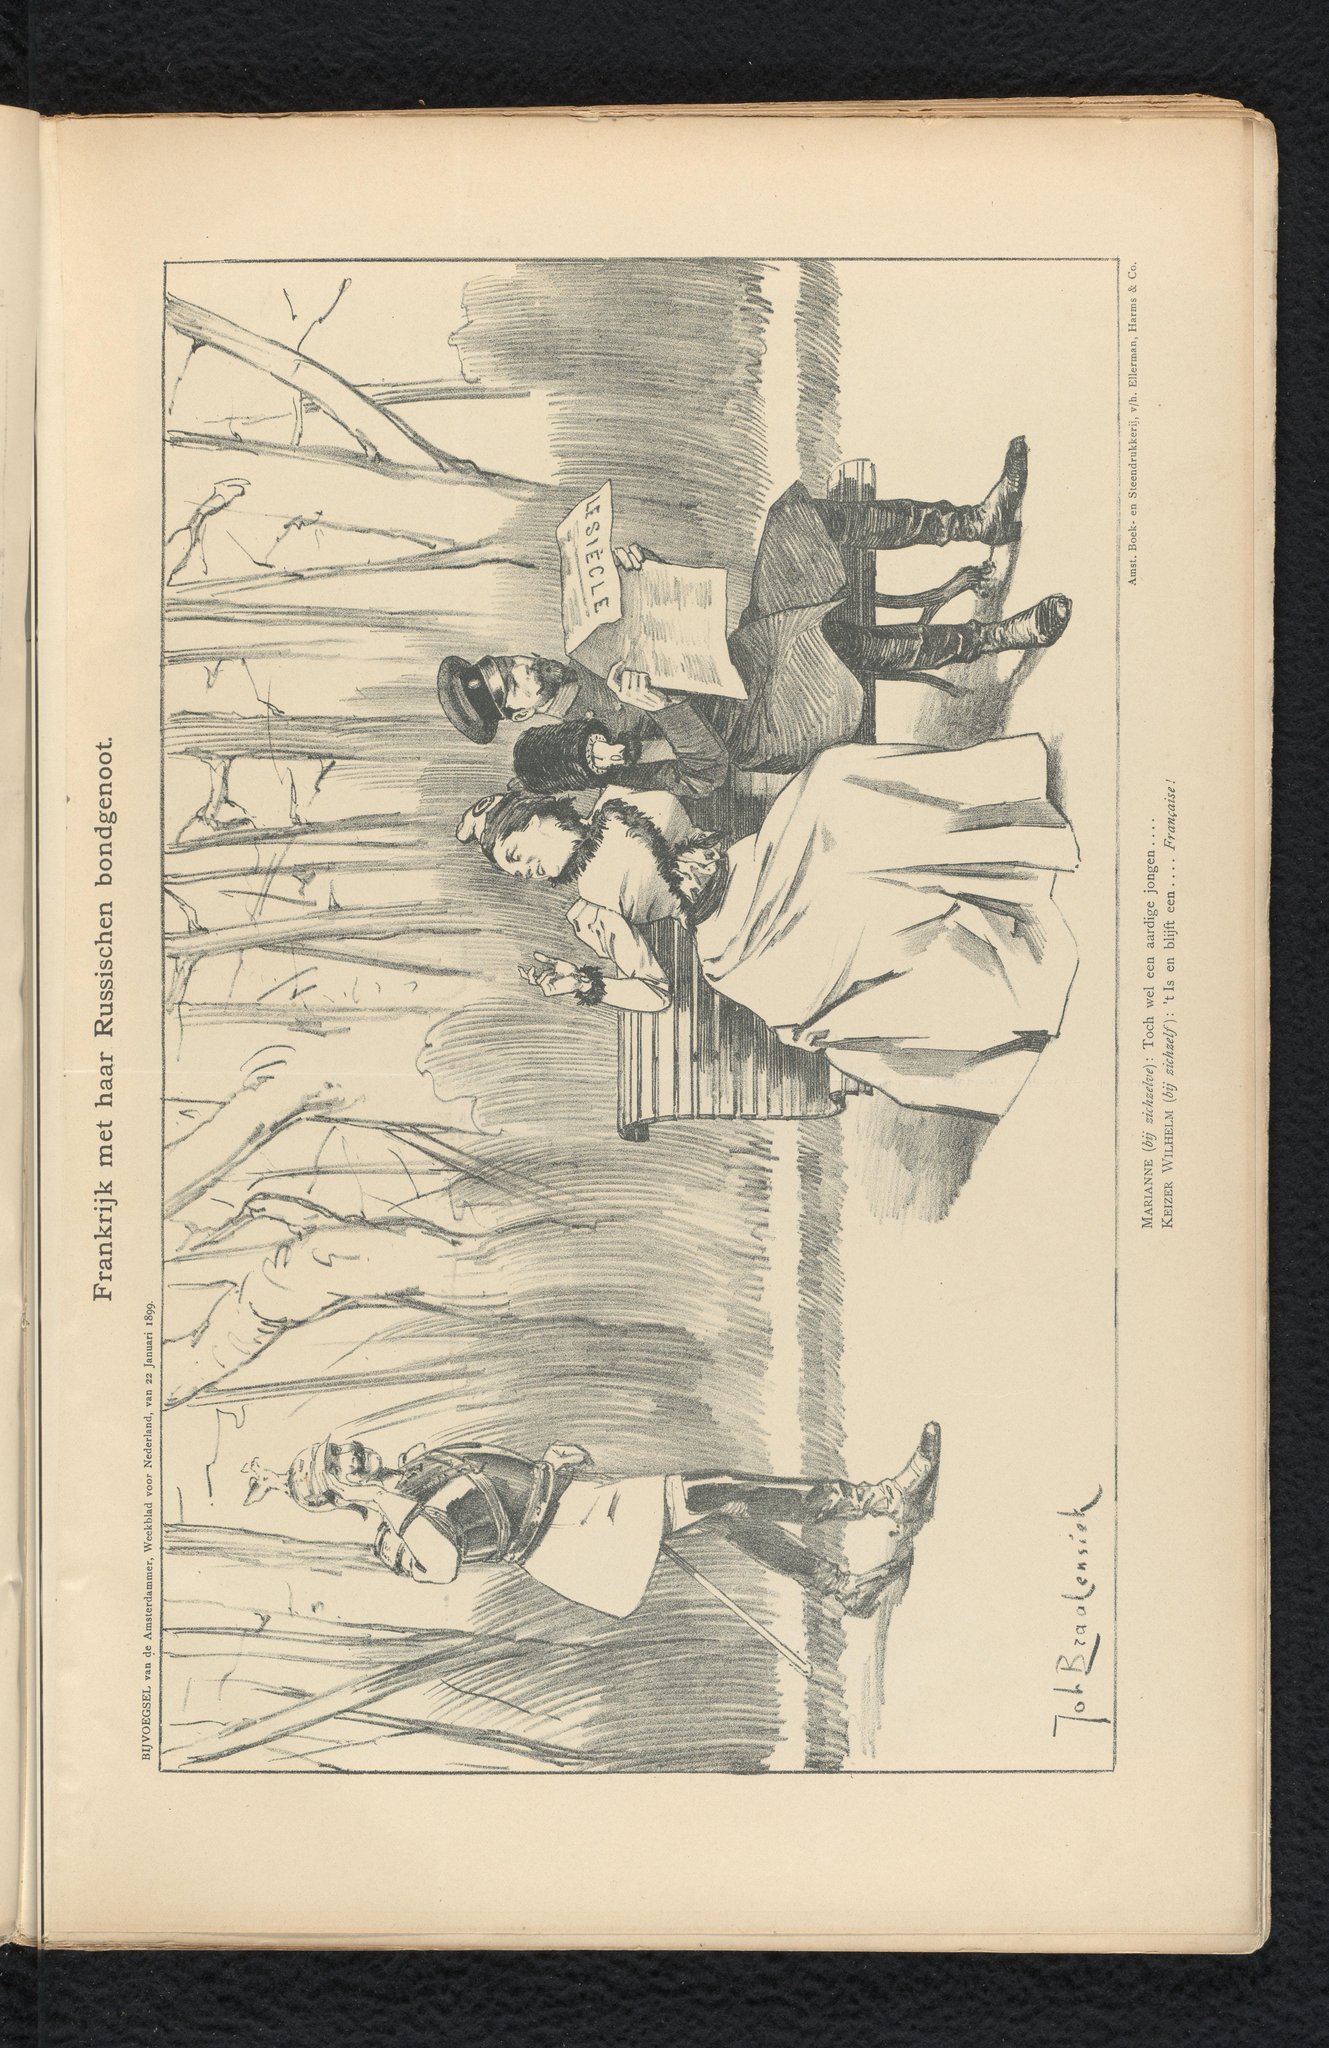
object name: cartoon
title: Frankrijk met haar Russischen bondgenoot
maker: johan braakensiek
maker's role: draughtsman, print maker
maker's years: 1858-1940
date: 1899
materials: paper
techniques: lithograph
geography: amsterdam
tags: wilhelm ii (keizer van duitsland), park, bench, personifications of countries, nations, states, districts, etc., political caricatures and satires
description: Marianne (Frankrijk), zittend op een parkbank met haar partner de Russische tsaar Nicolaas II, draait zich om en begroet de Duitse keizer Wilhelm II.